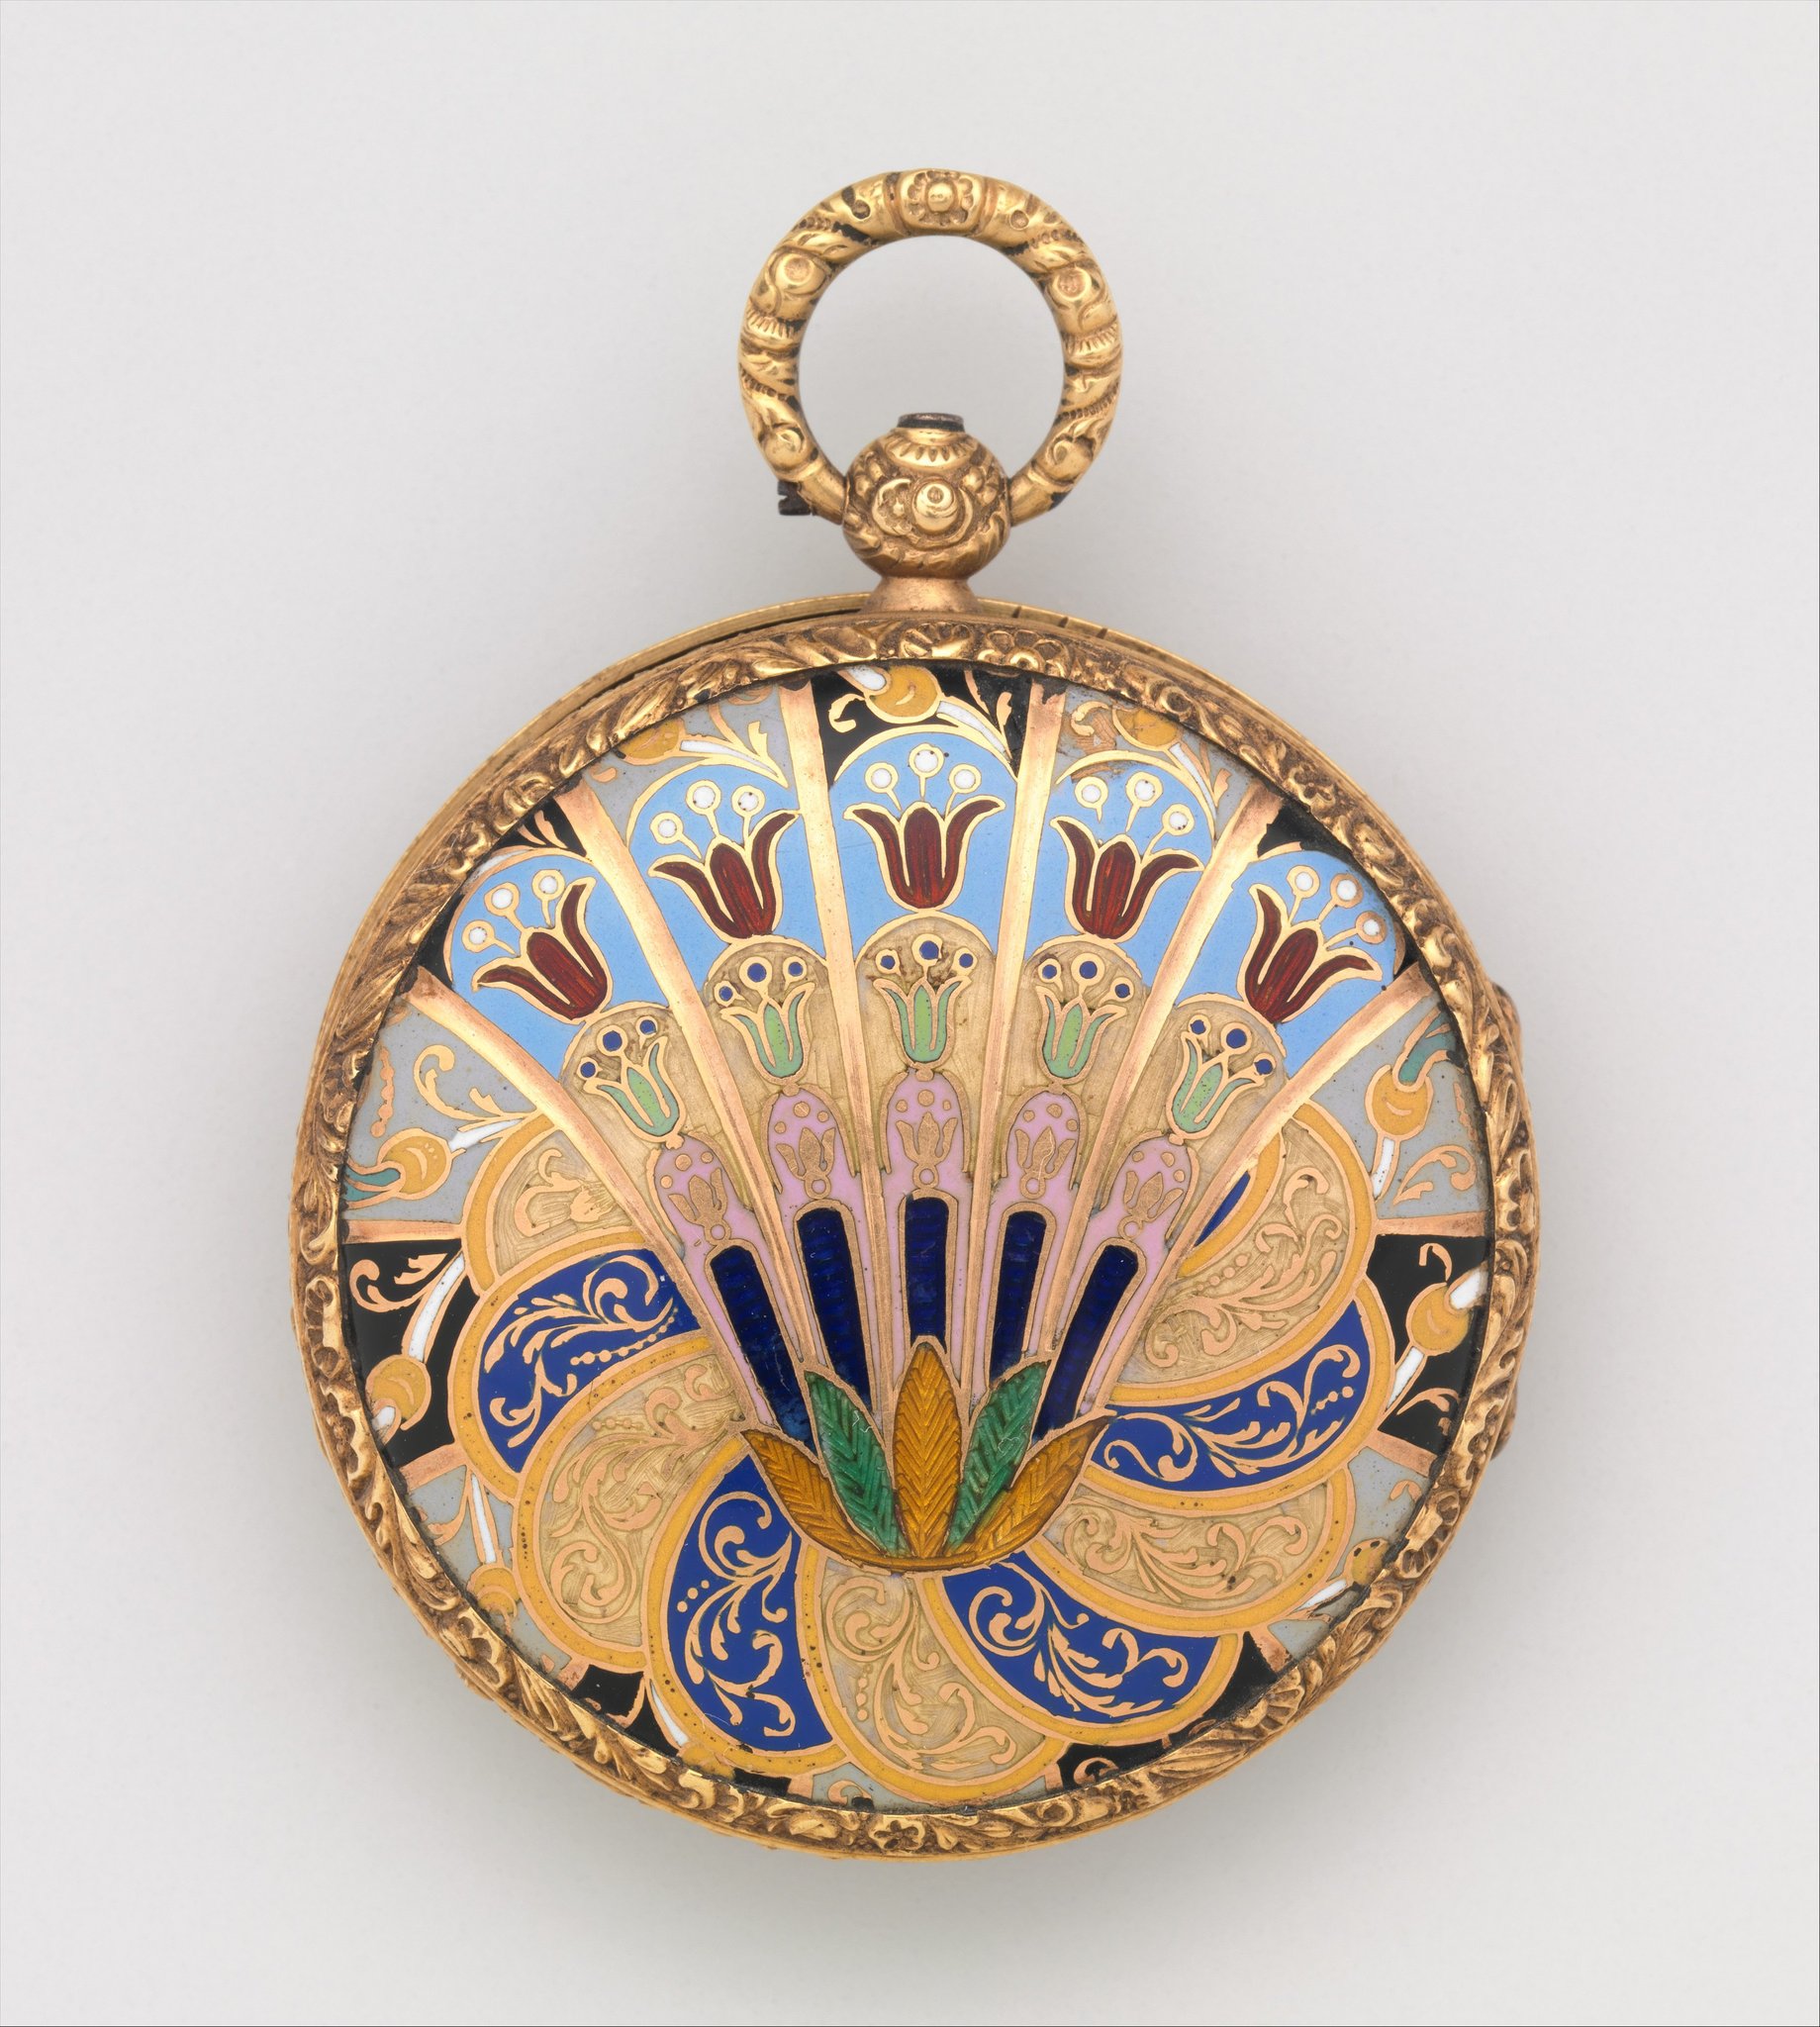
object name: watch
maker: firm of frères wiss et menu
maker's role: maker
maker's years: 1787-1810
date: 1820-1830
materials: enamel, gold, silver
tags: flowers